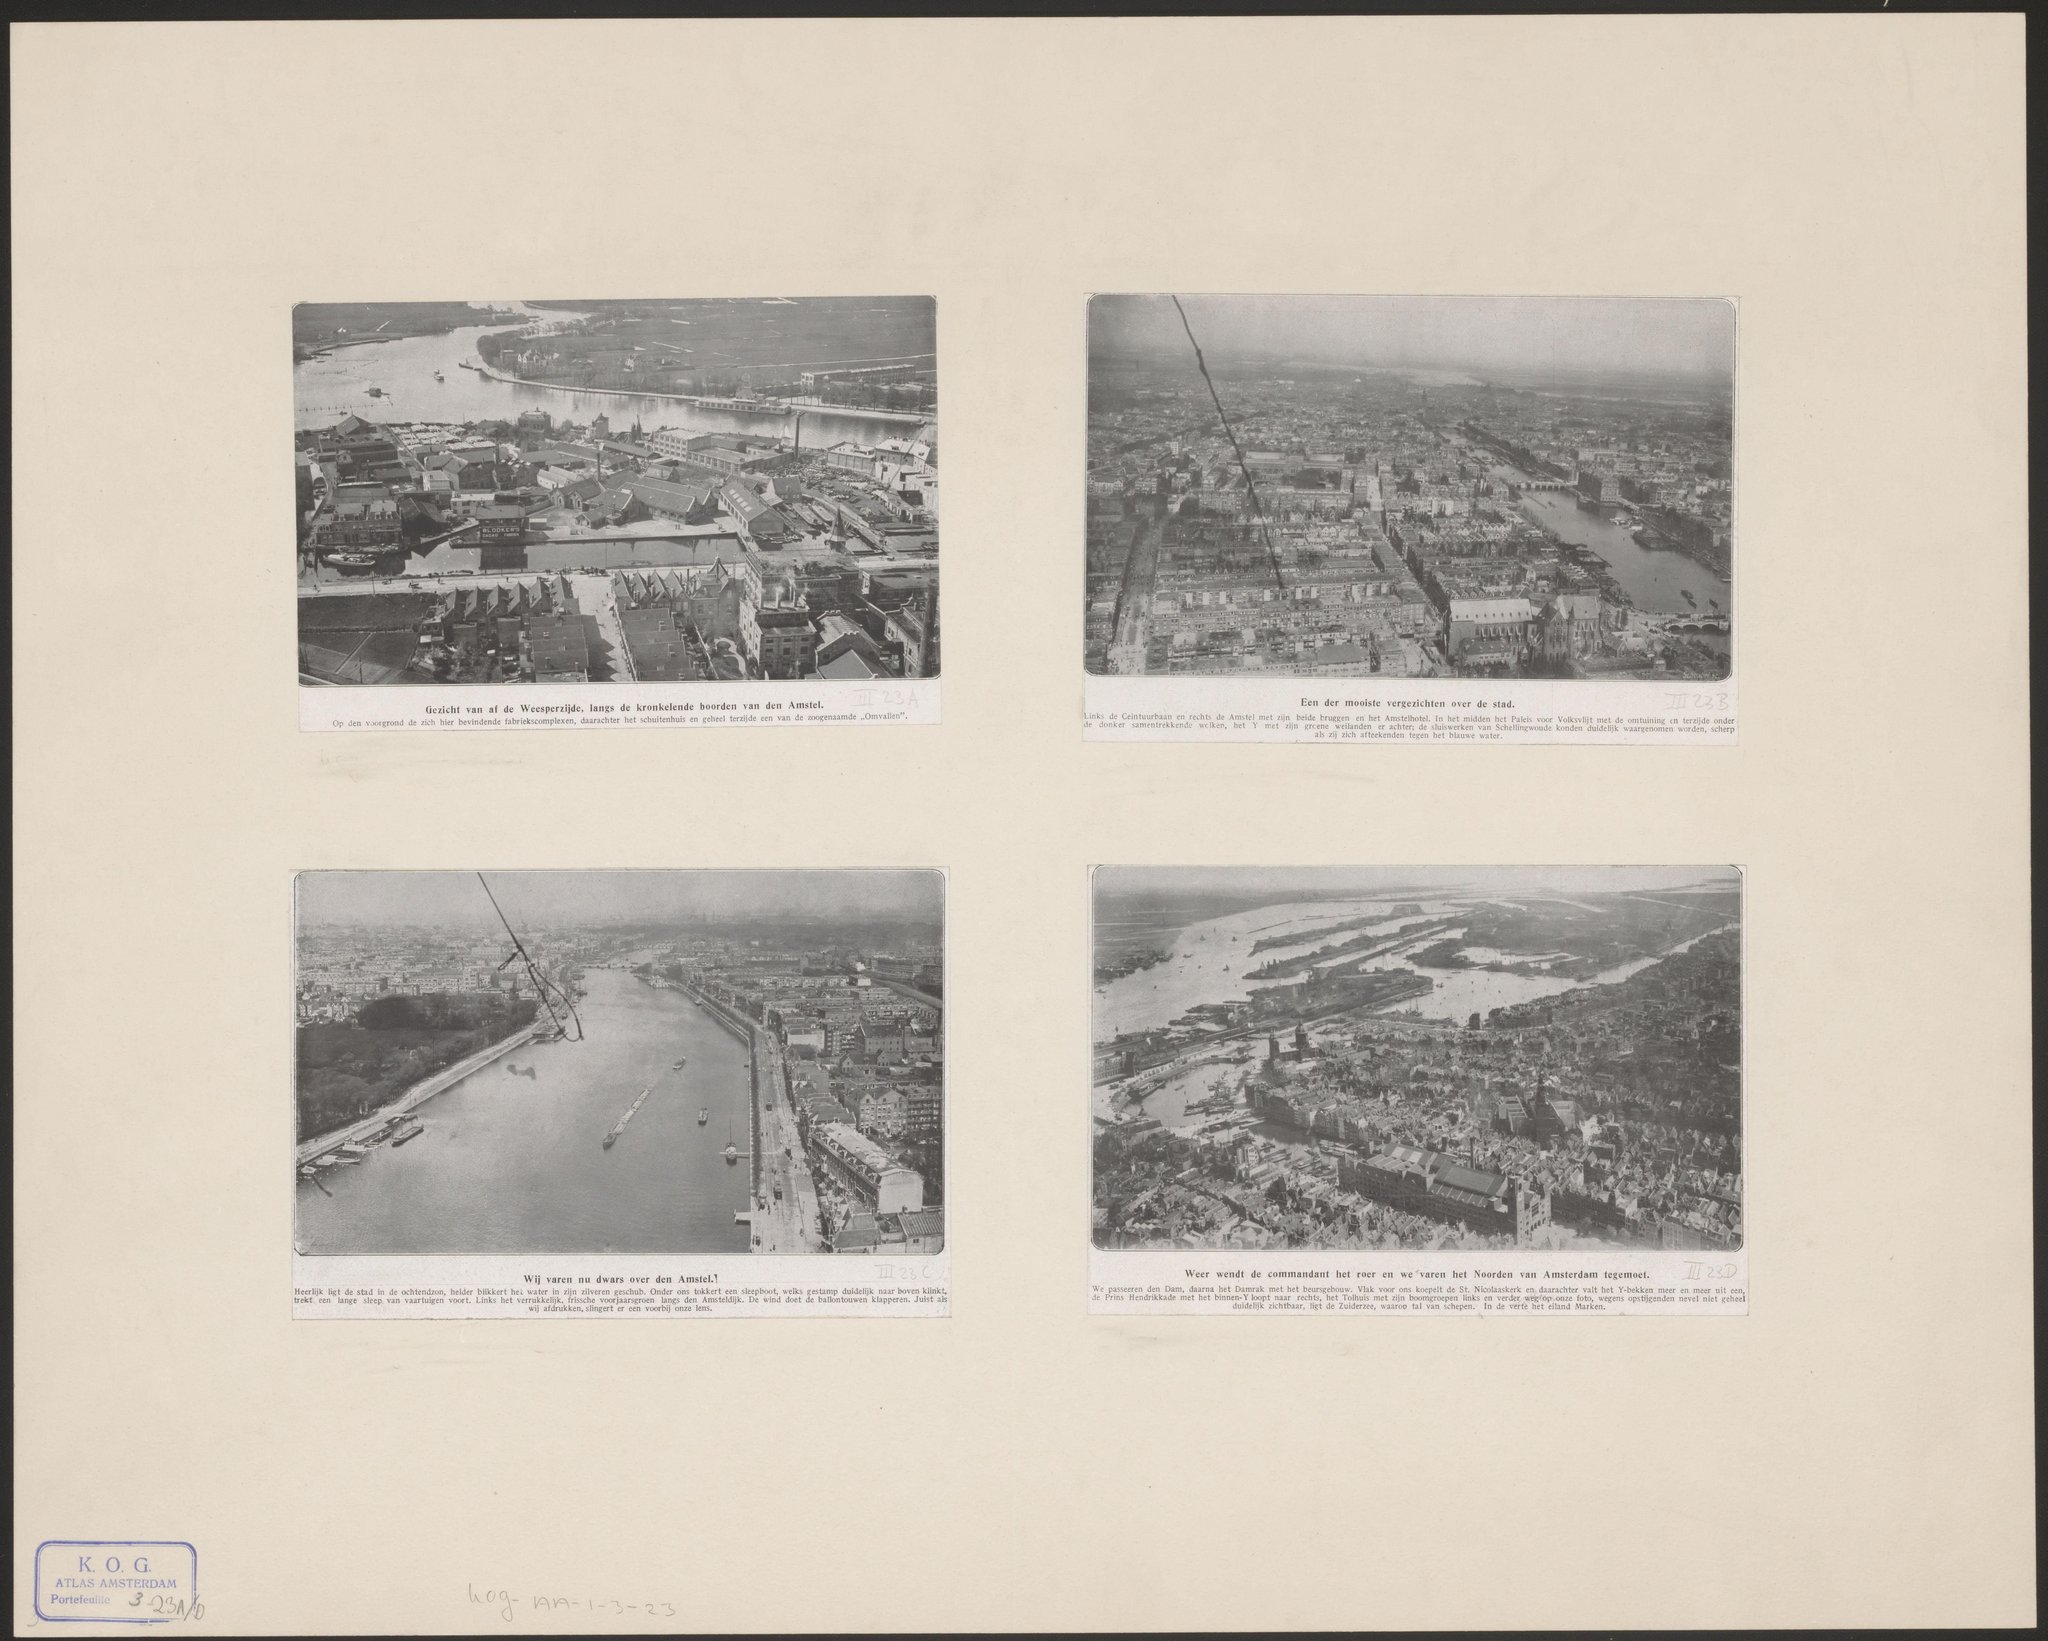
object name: photomechanical print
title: Gezichten op de Weesperzijde, het Paleis voor Volksvlijt, de Amstel en omgeving rond Station Amsterdam Centraal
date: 1880-1950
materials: paper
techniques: letterpress printing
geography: amsterdam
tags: prospect of city, town panorama, silhouette of city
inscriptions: collector's mark: ‘3 23A/D’ Lugt 1641b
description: Onderwerpsrubriek binnen de Atlas Amsterdam: Panorama's en verzamelprenten.